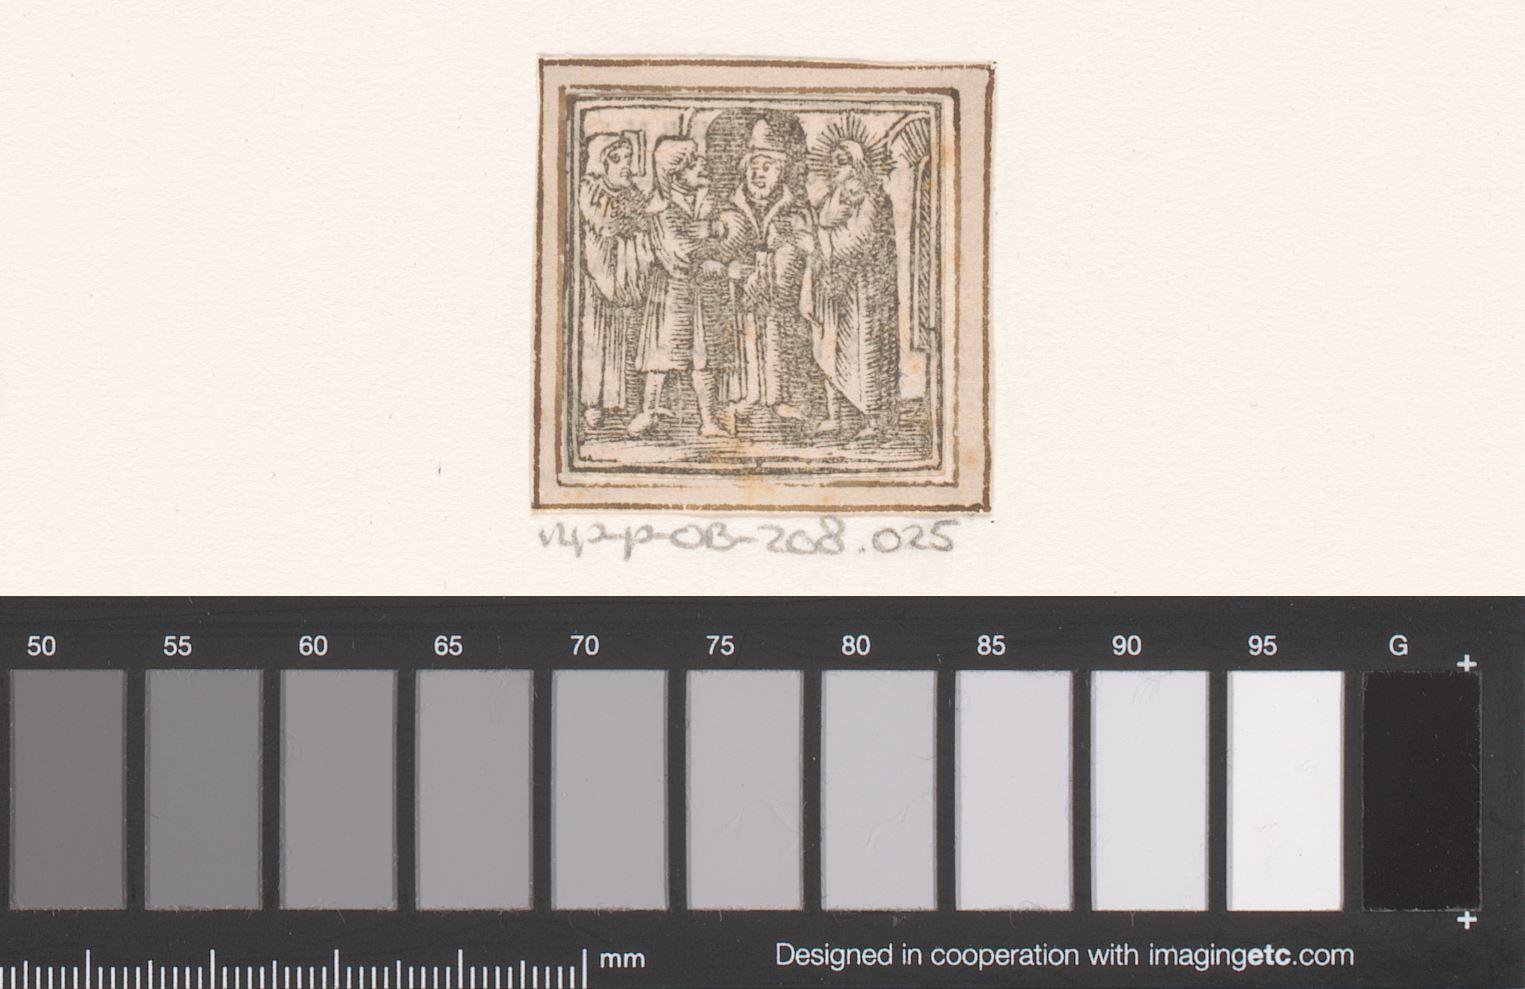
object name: print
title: Christus in gesprek met Farizeeërs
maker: Anonymous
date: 1600-1699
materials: paper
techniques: woodcut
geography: netherlands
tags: pharisees and sadducees opposing christ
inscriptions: collector's mark: Lugt 2228